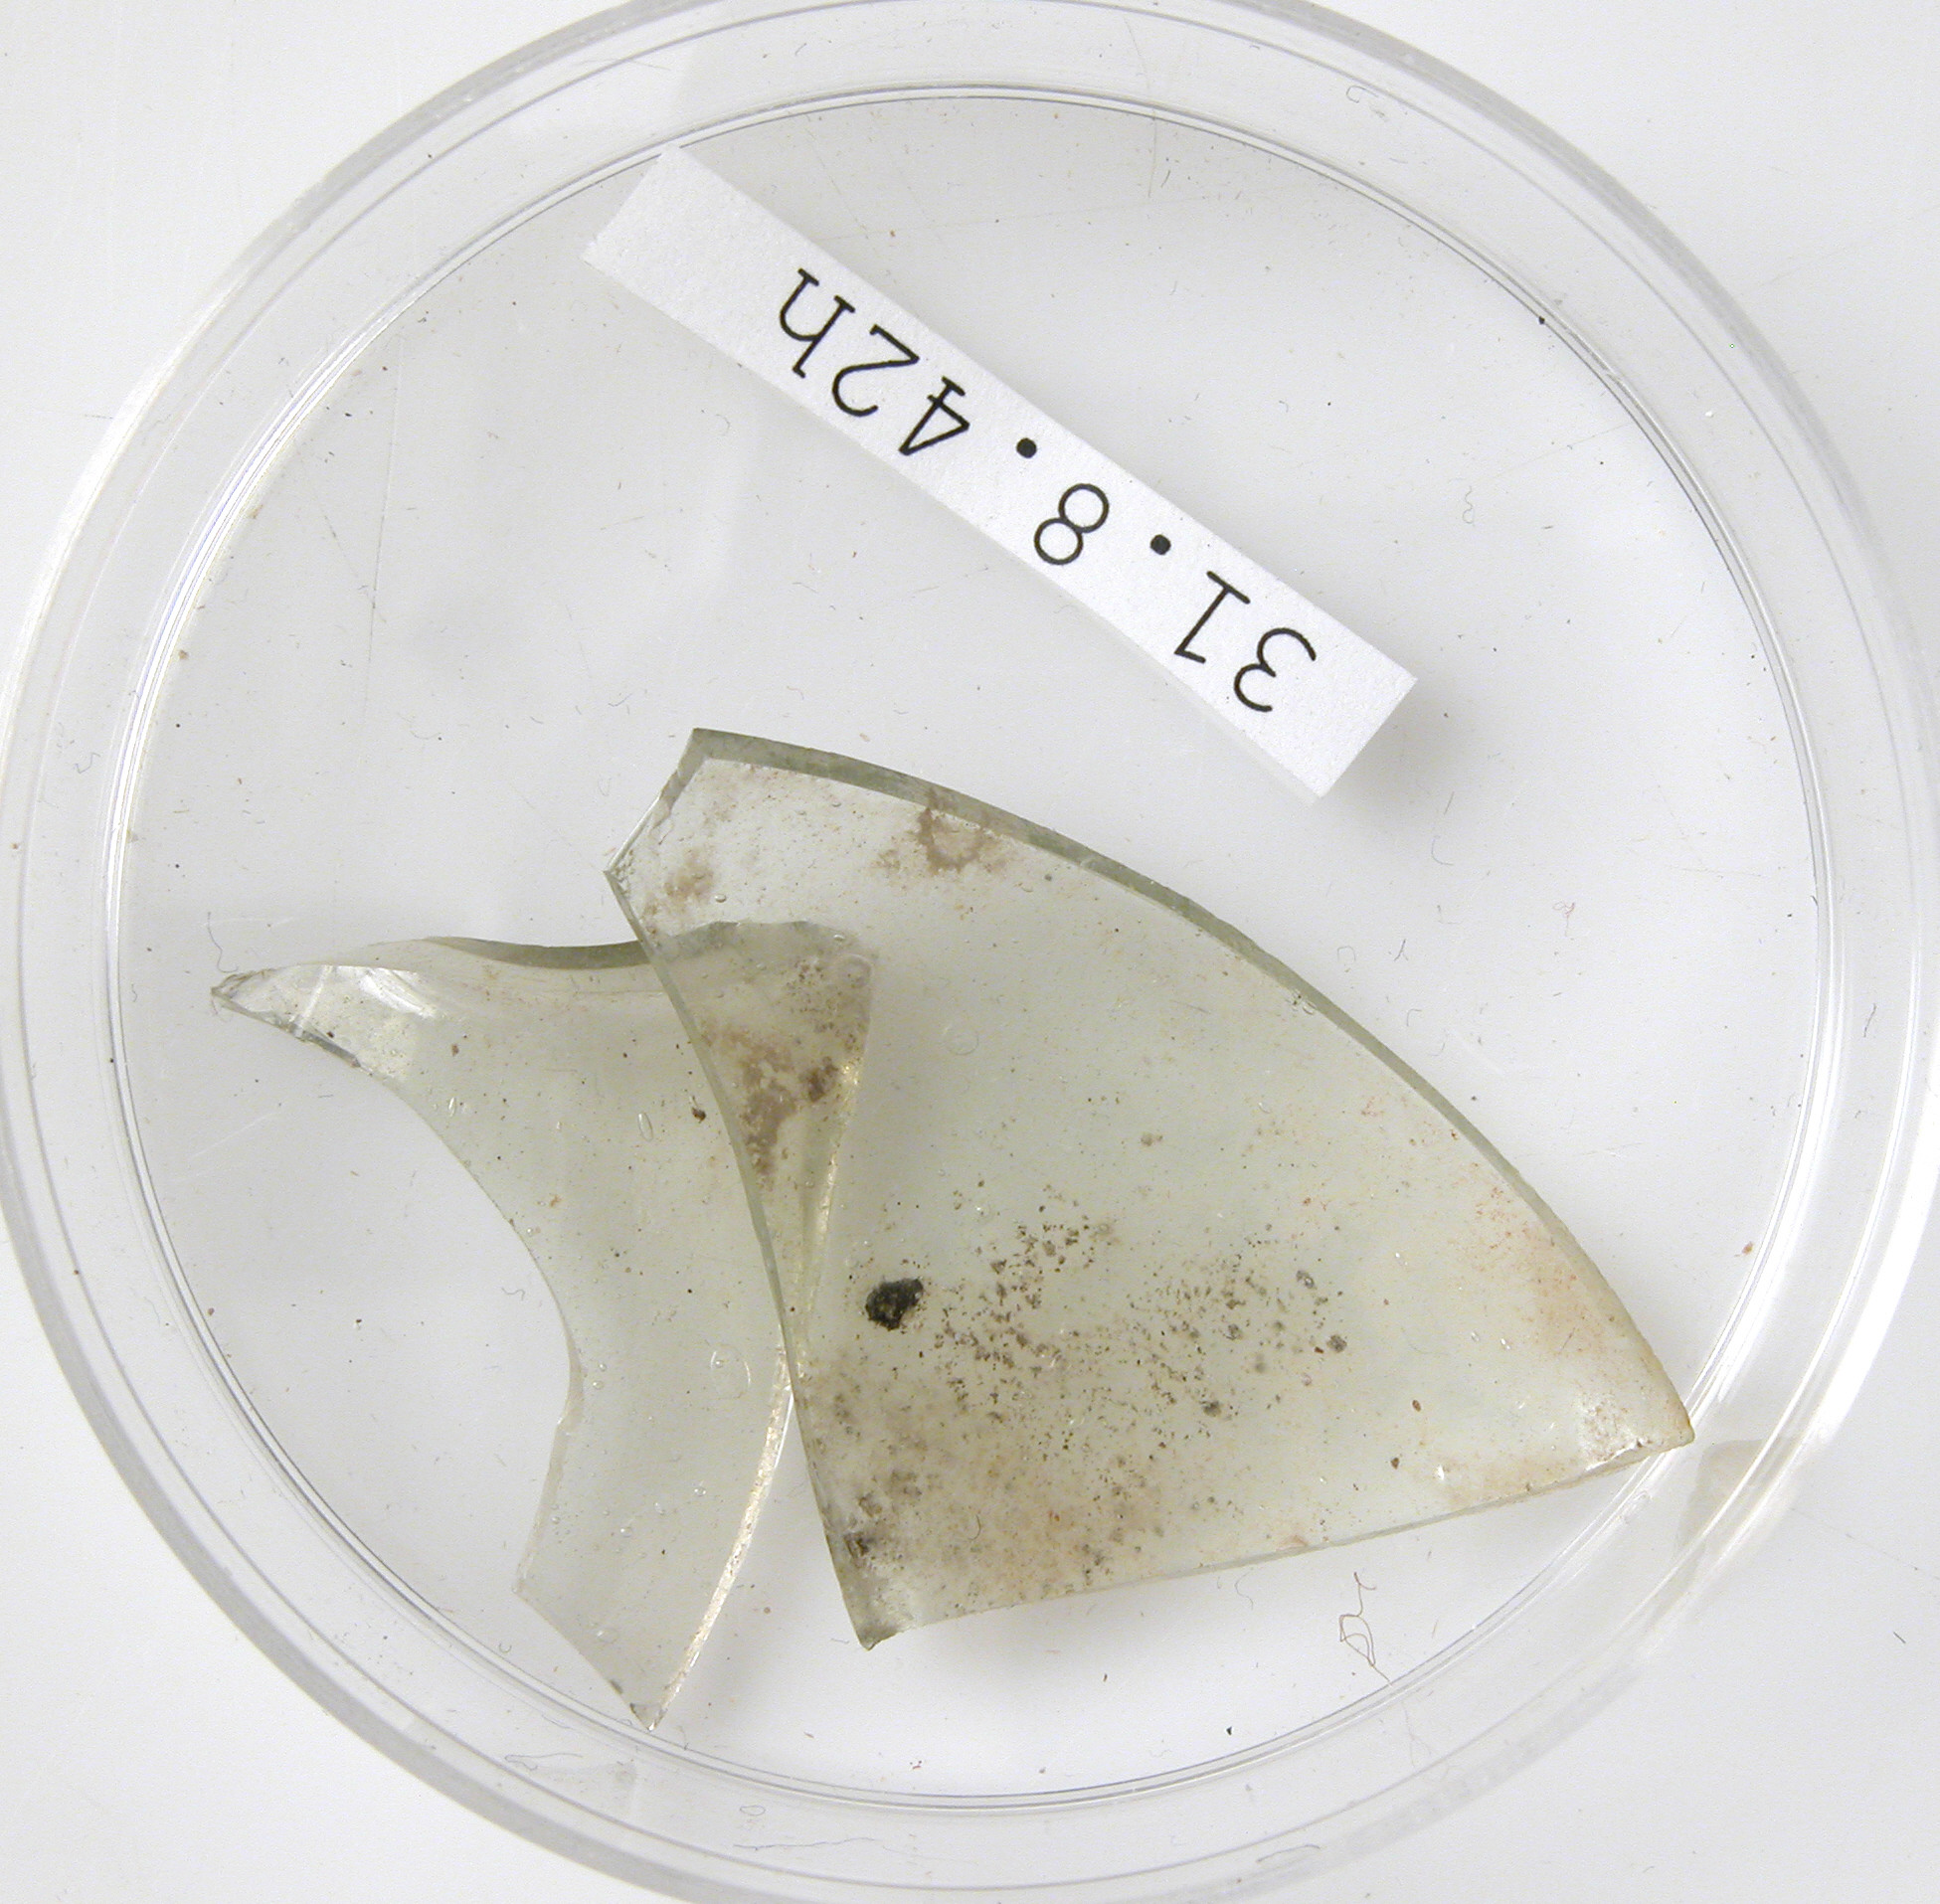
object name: fragment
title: Glass Fragments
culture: coptic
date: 301-400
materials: glass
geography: egypt